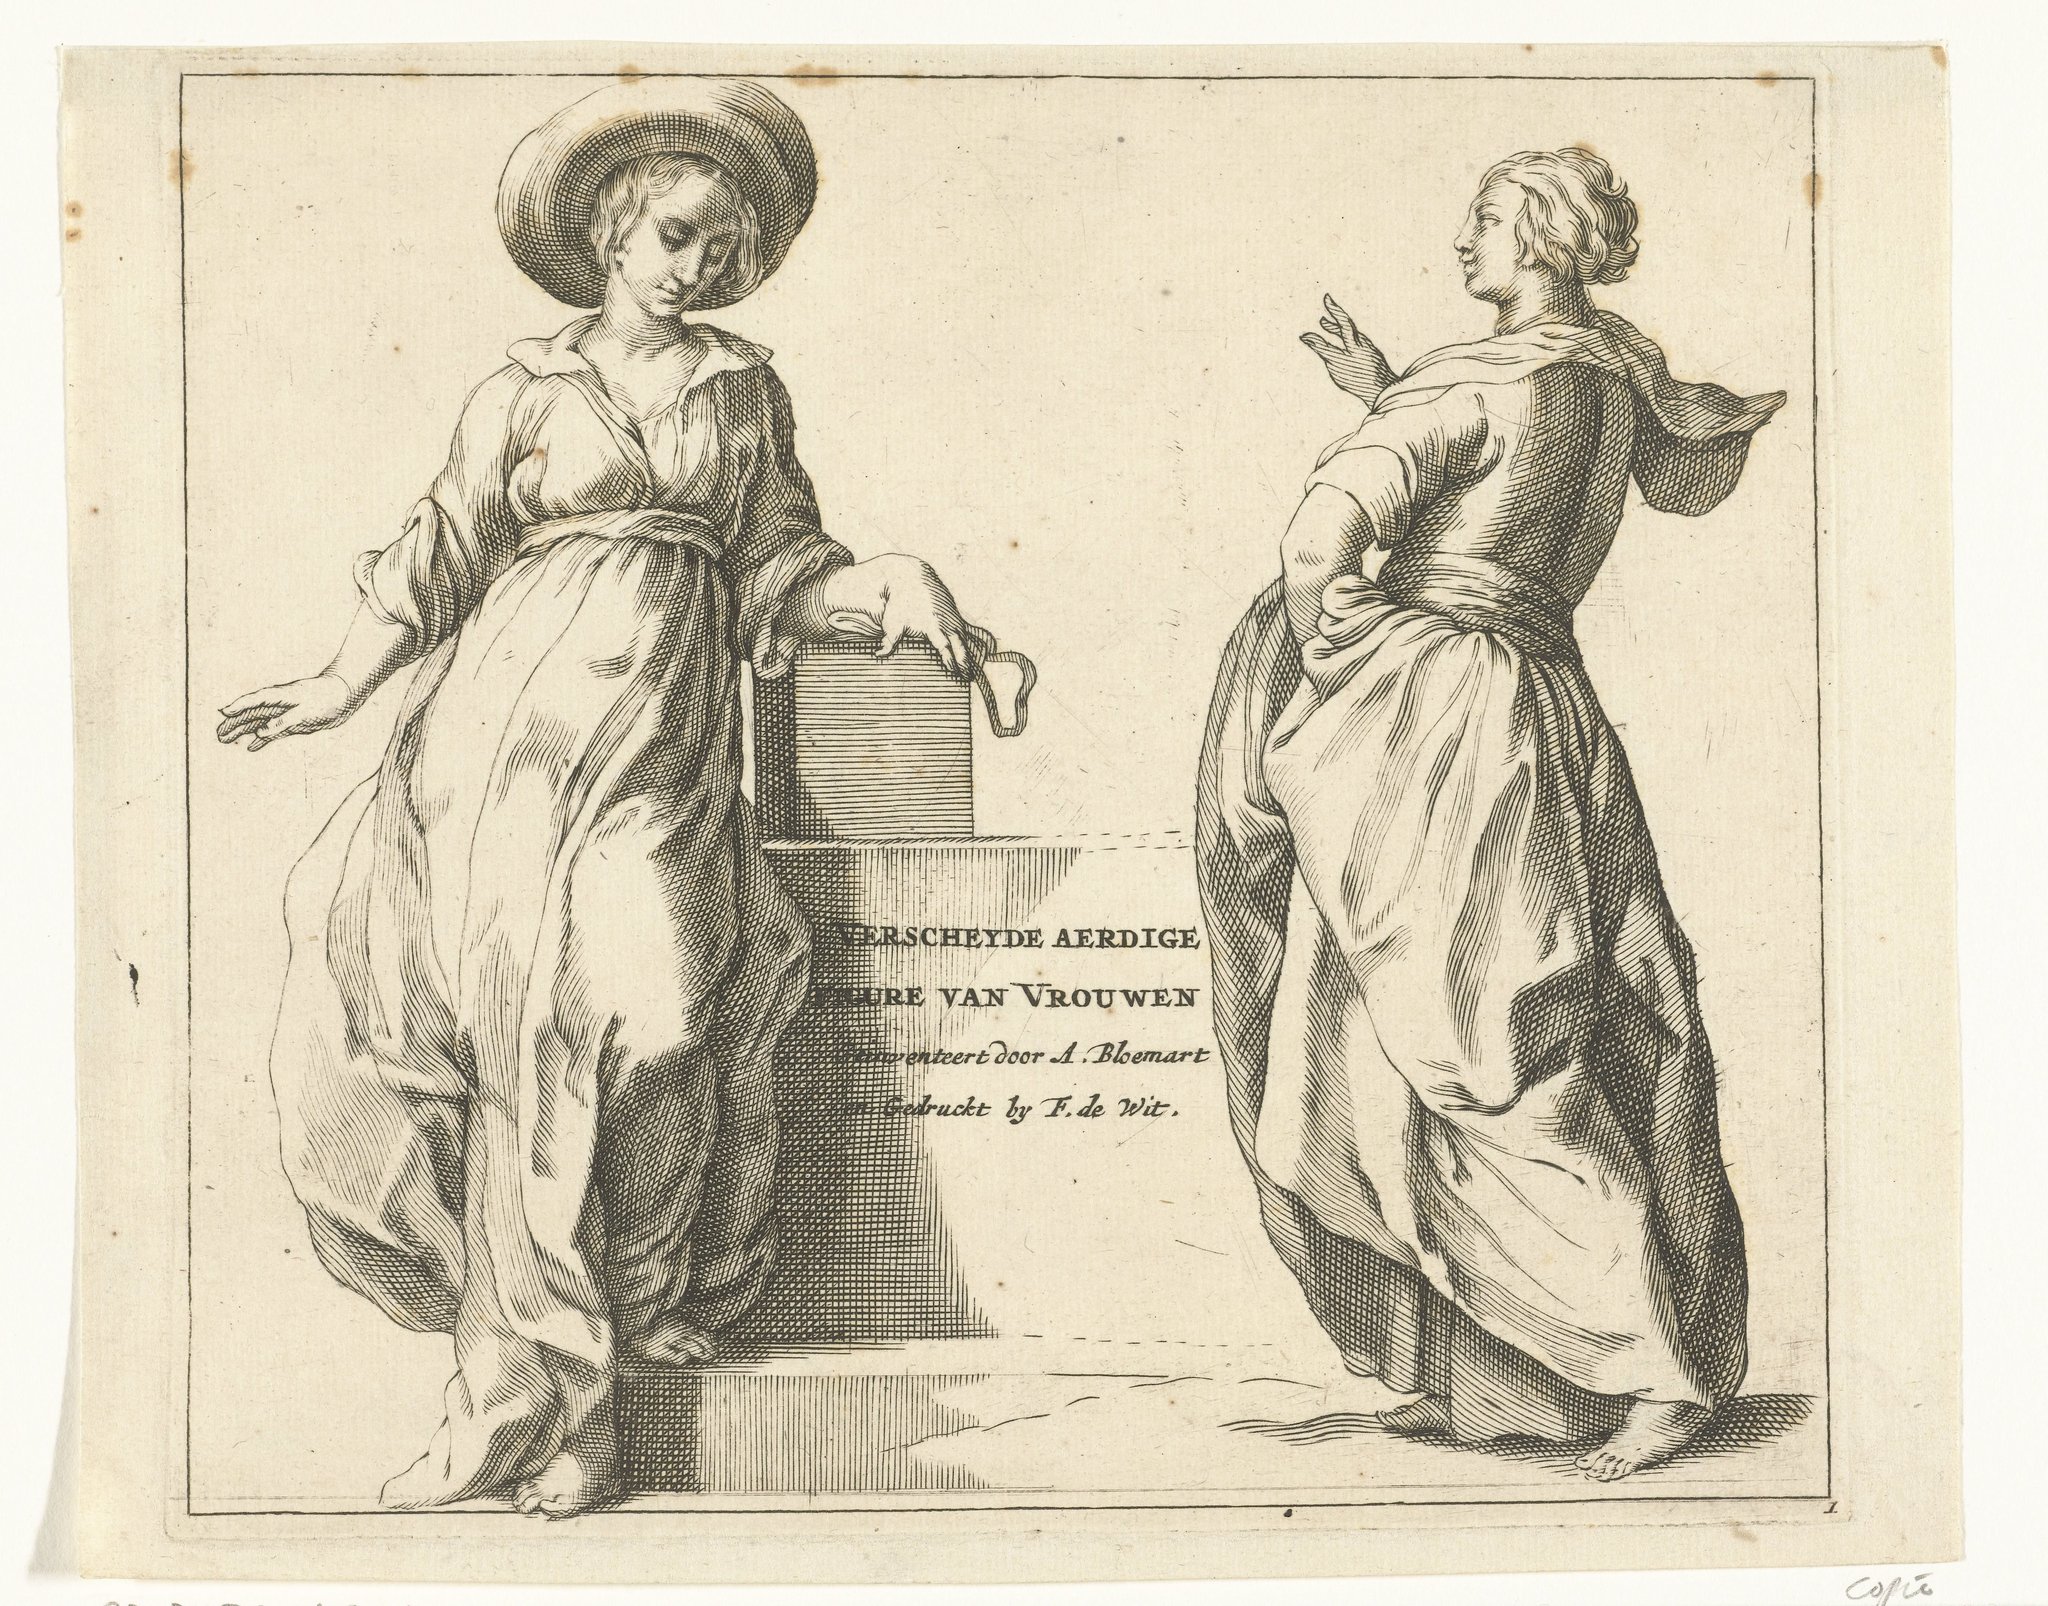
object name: book illustration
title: November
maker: Anonymous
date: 1600-1699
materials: paper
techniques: letterpress printing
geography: netherlands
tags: predatory birds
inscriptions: collector's mark: Lugt 2228